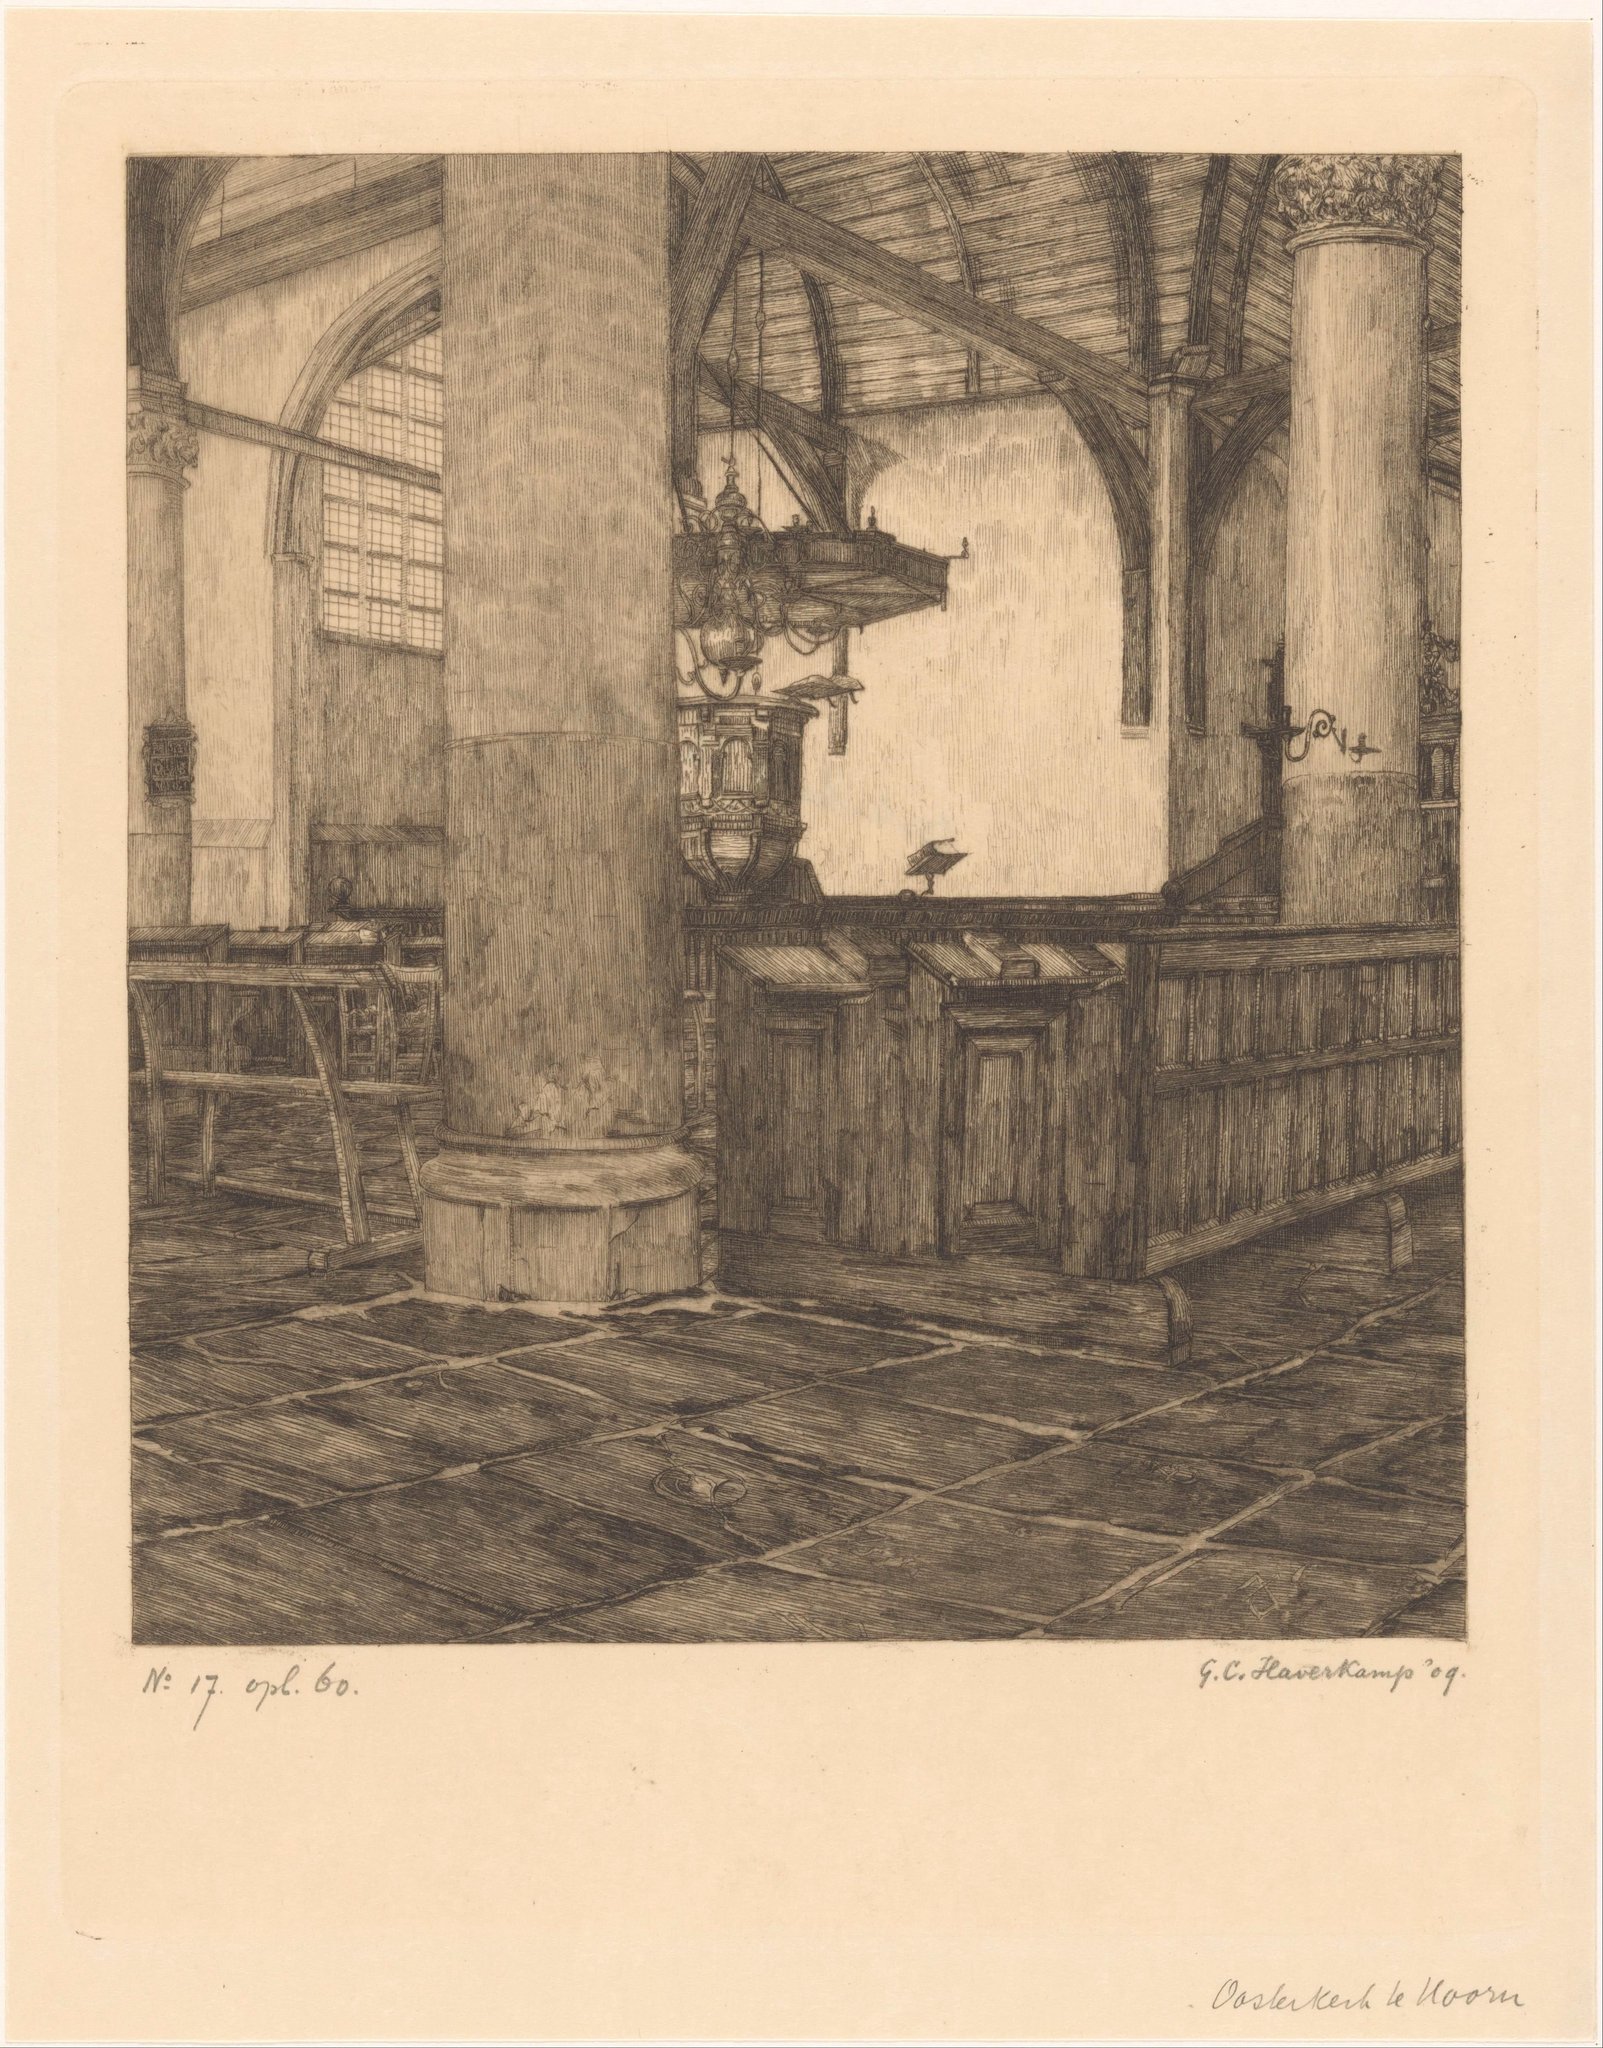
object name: print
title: Oosterkerk te Hoorn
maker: gerrit haverkamp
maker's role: print maker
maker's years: 1872-1926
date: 1909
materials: paper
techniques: etching, intaglio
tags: interior of church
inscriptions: collector's mark: Lugt 2228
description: Het interieur van de Oosterkerk in Hoorn.